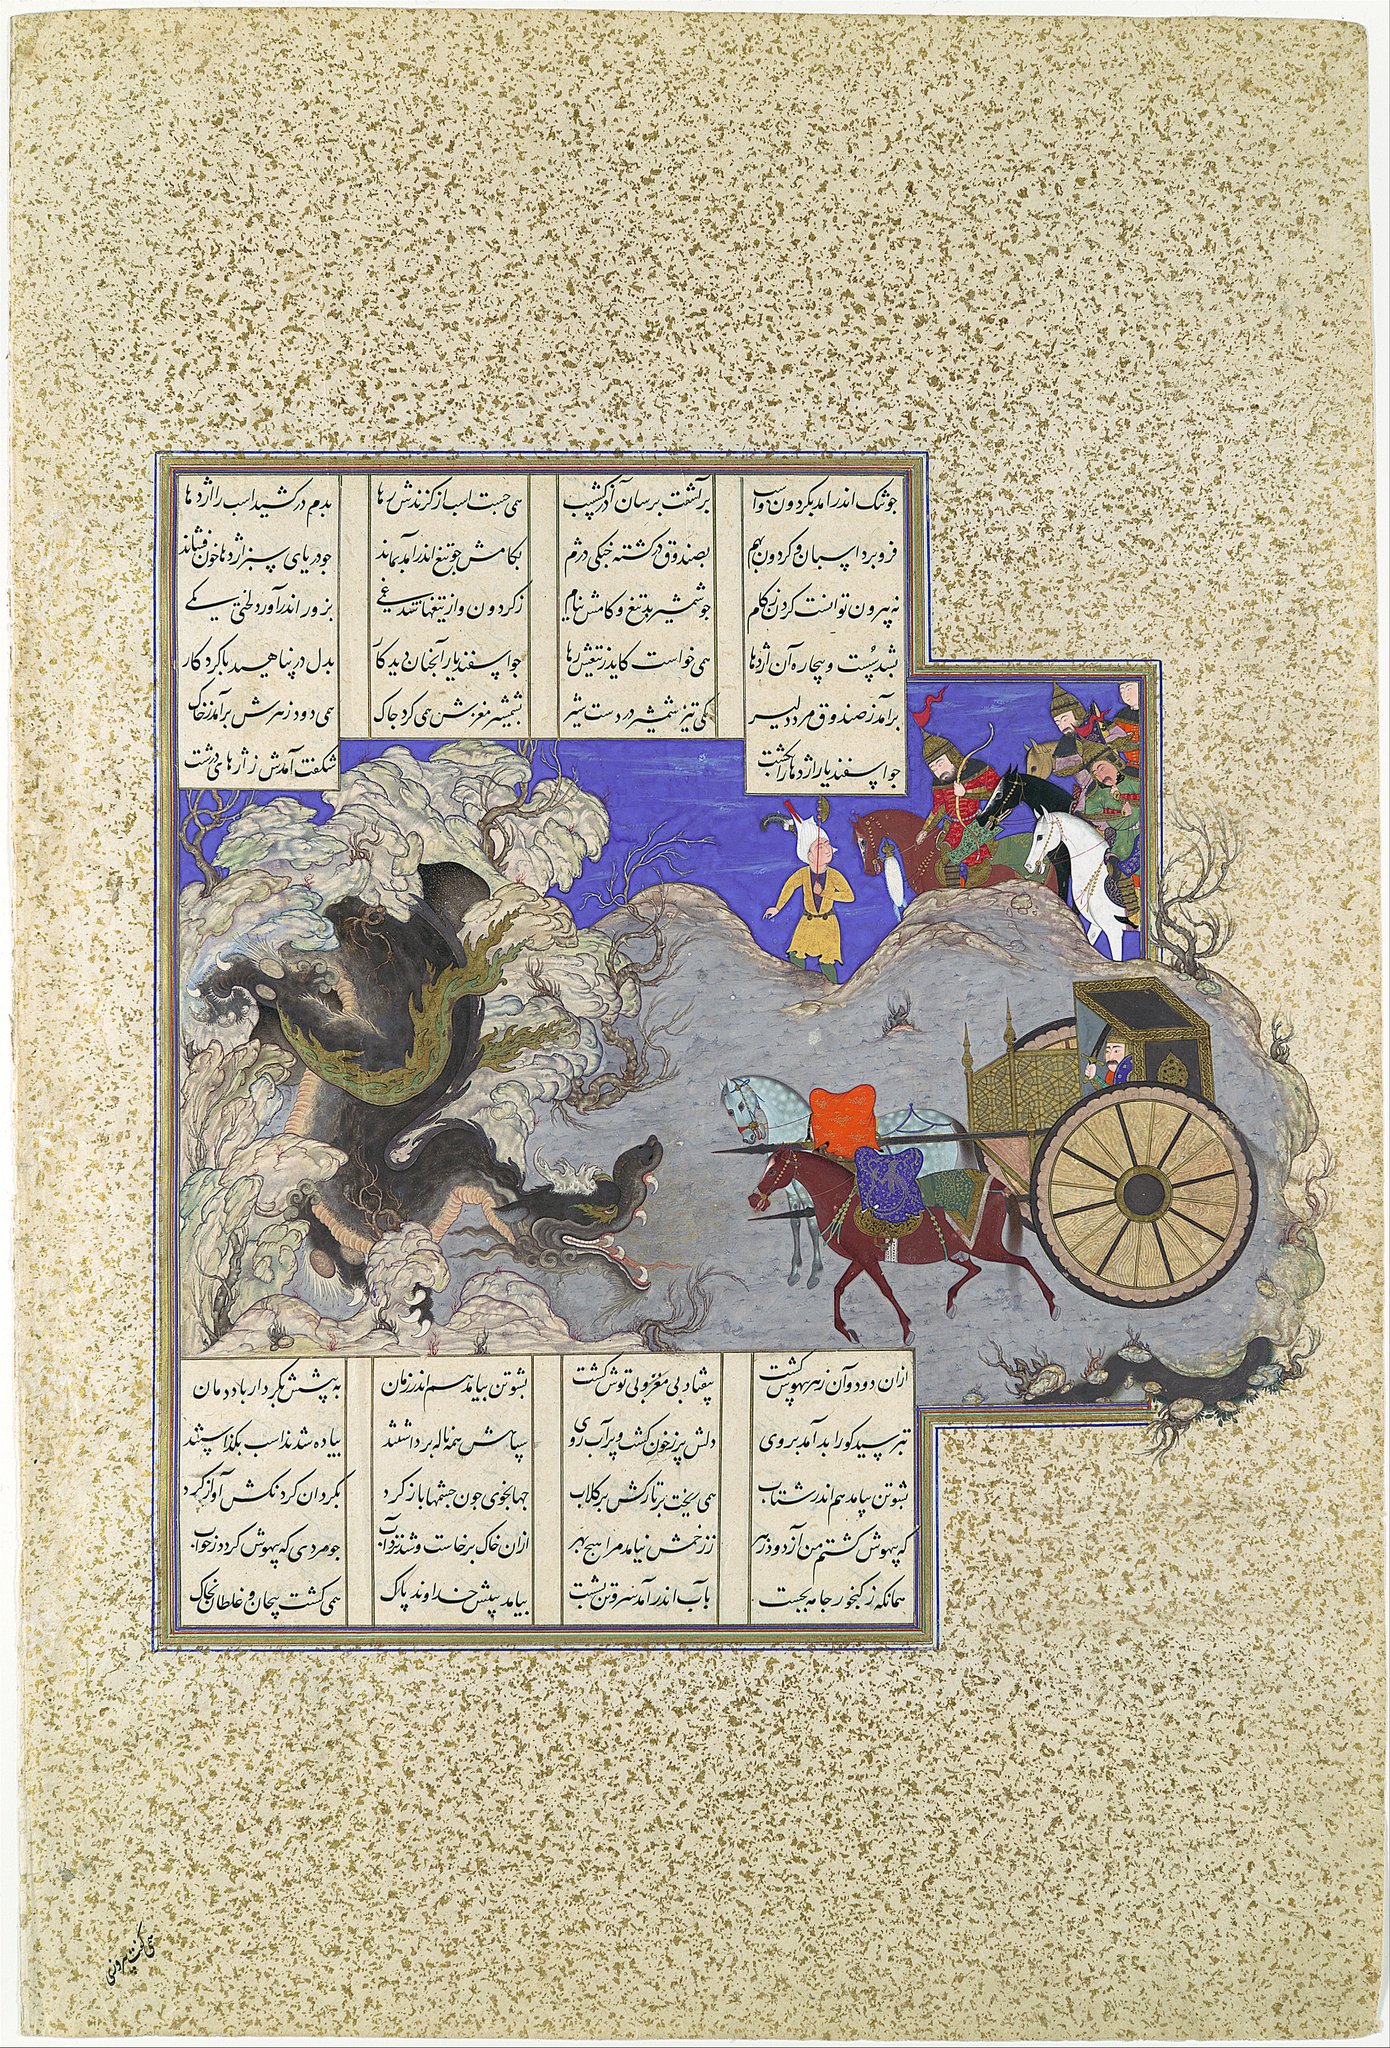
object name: folio from an illustrated manuscript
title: "Isfandiyar's Third Course: He Slays a Dragon", Folio 434v from the Shahnama (Book of Kings) of Shah Tahmasp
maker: abu'l qasim firdausi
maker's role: author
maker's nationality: iranian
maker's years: 935-1020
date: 1530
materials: gold, ink, paper, silver, watercolor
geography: iran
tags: men,dragons,horses,carriages